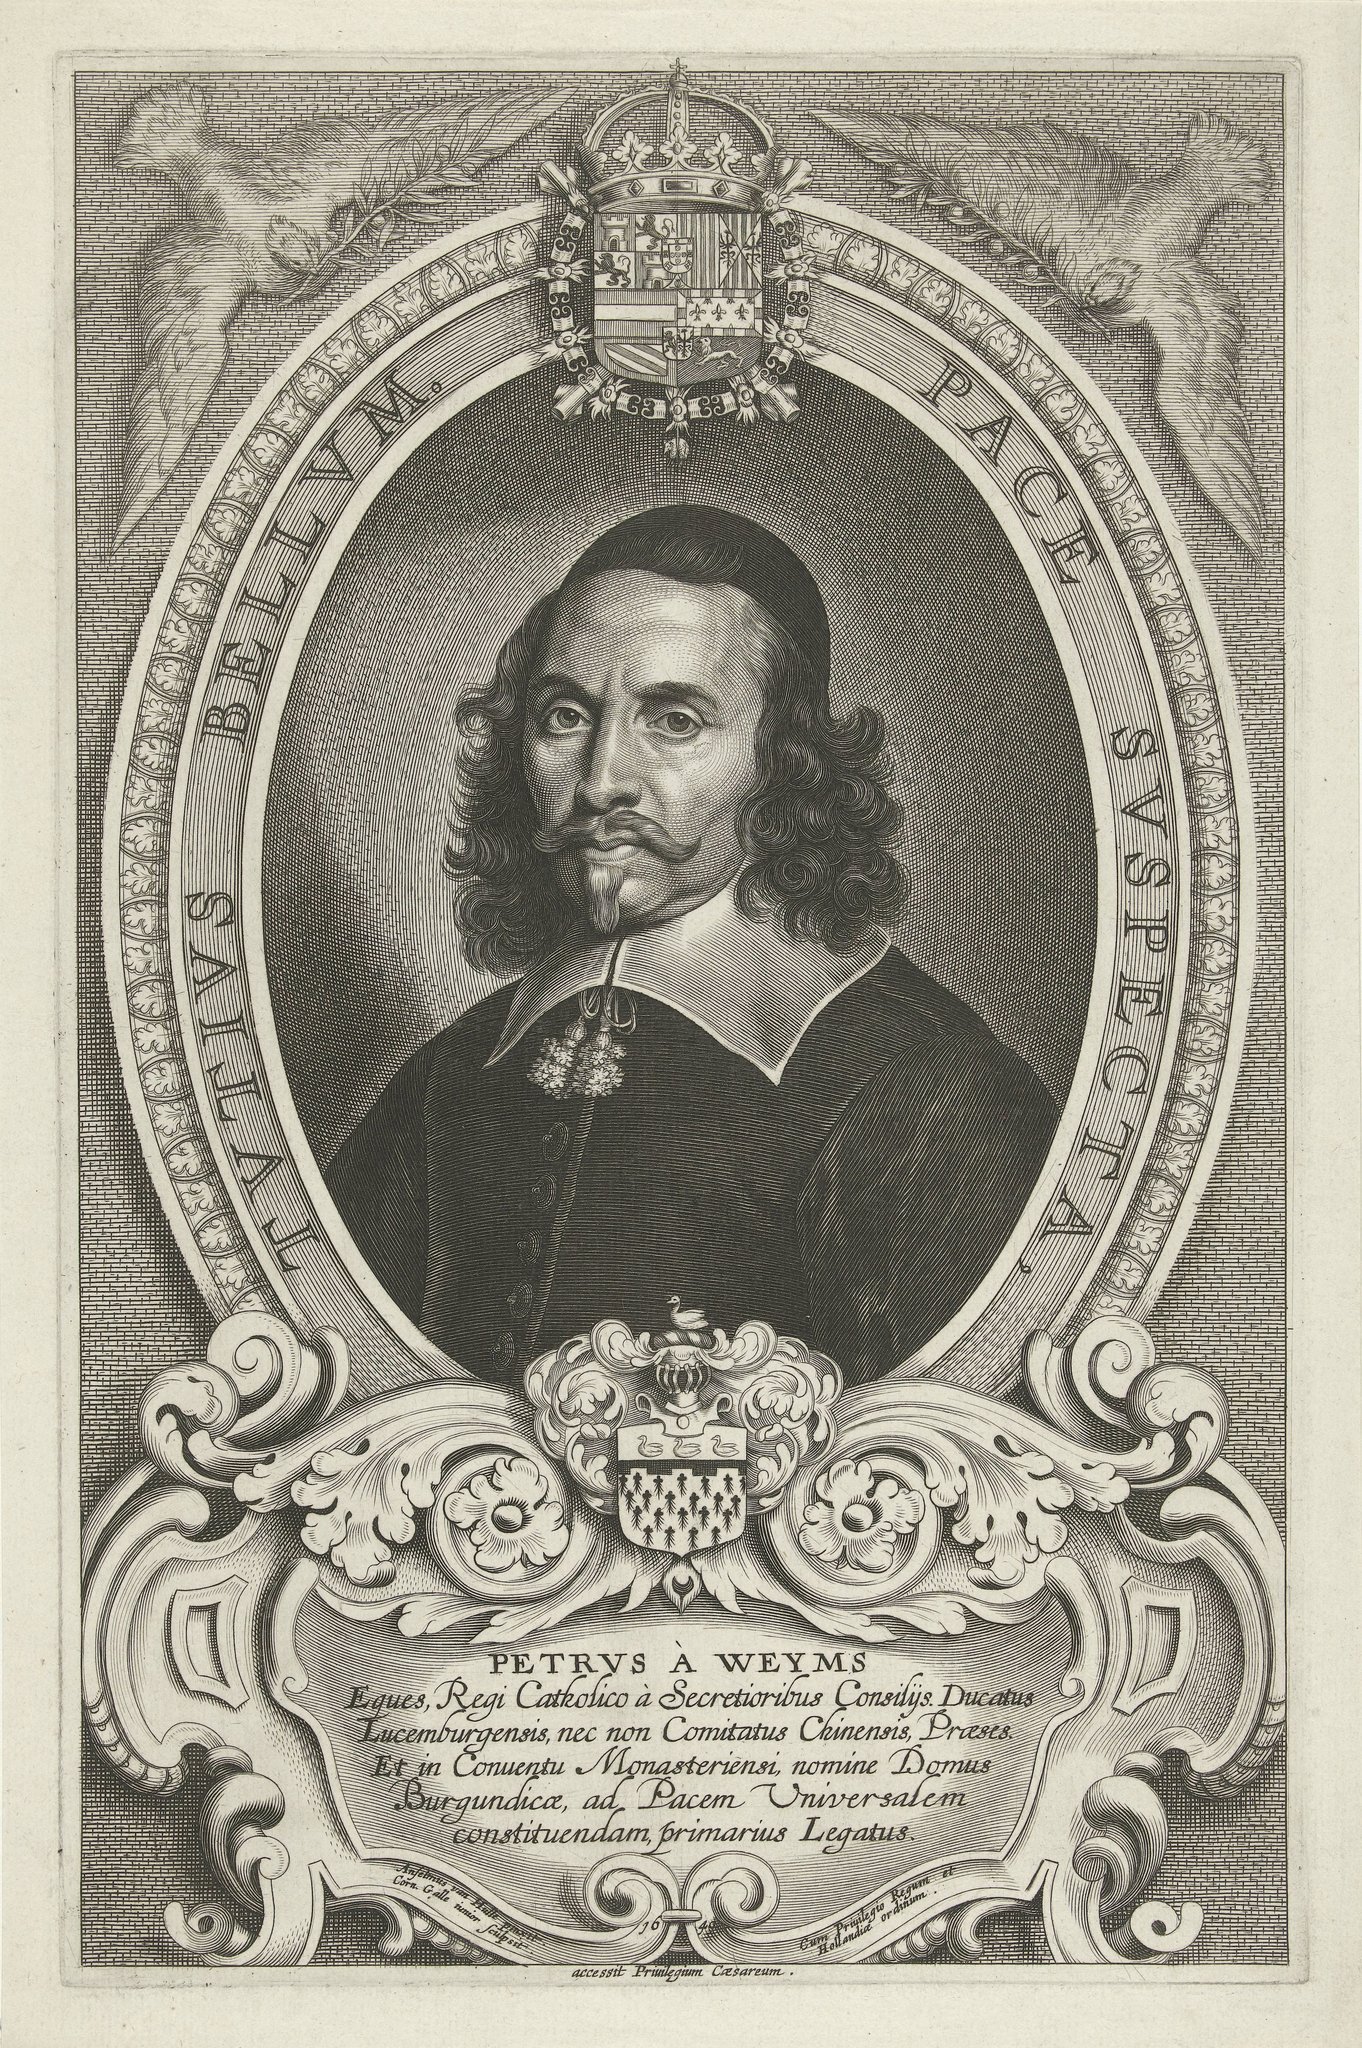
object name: print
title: Celeberrimi ad pacificandum Christiani nominis orbem legati Monasterium et Osnabrugas (...)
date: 1649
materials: paper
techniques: engraving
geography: antwerp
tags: president, pieter van weyms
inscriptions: collector's mark: Lugt 2228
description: Portret van Petrus Weyms, afgezant van Luxemburg tijdens de onderhandelingen voor de Vrede van Münster. Portret in ovaal met motto: Pace suspecta, tutius bellum. Boven het wapen van Luxemburg, onder Weyms' ridderwapen. In de bovenhoeken twee vredesduiven.